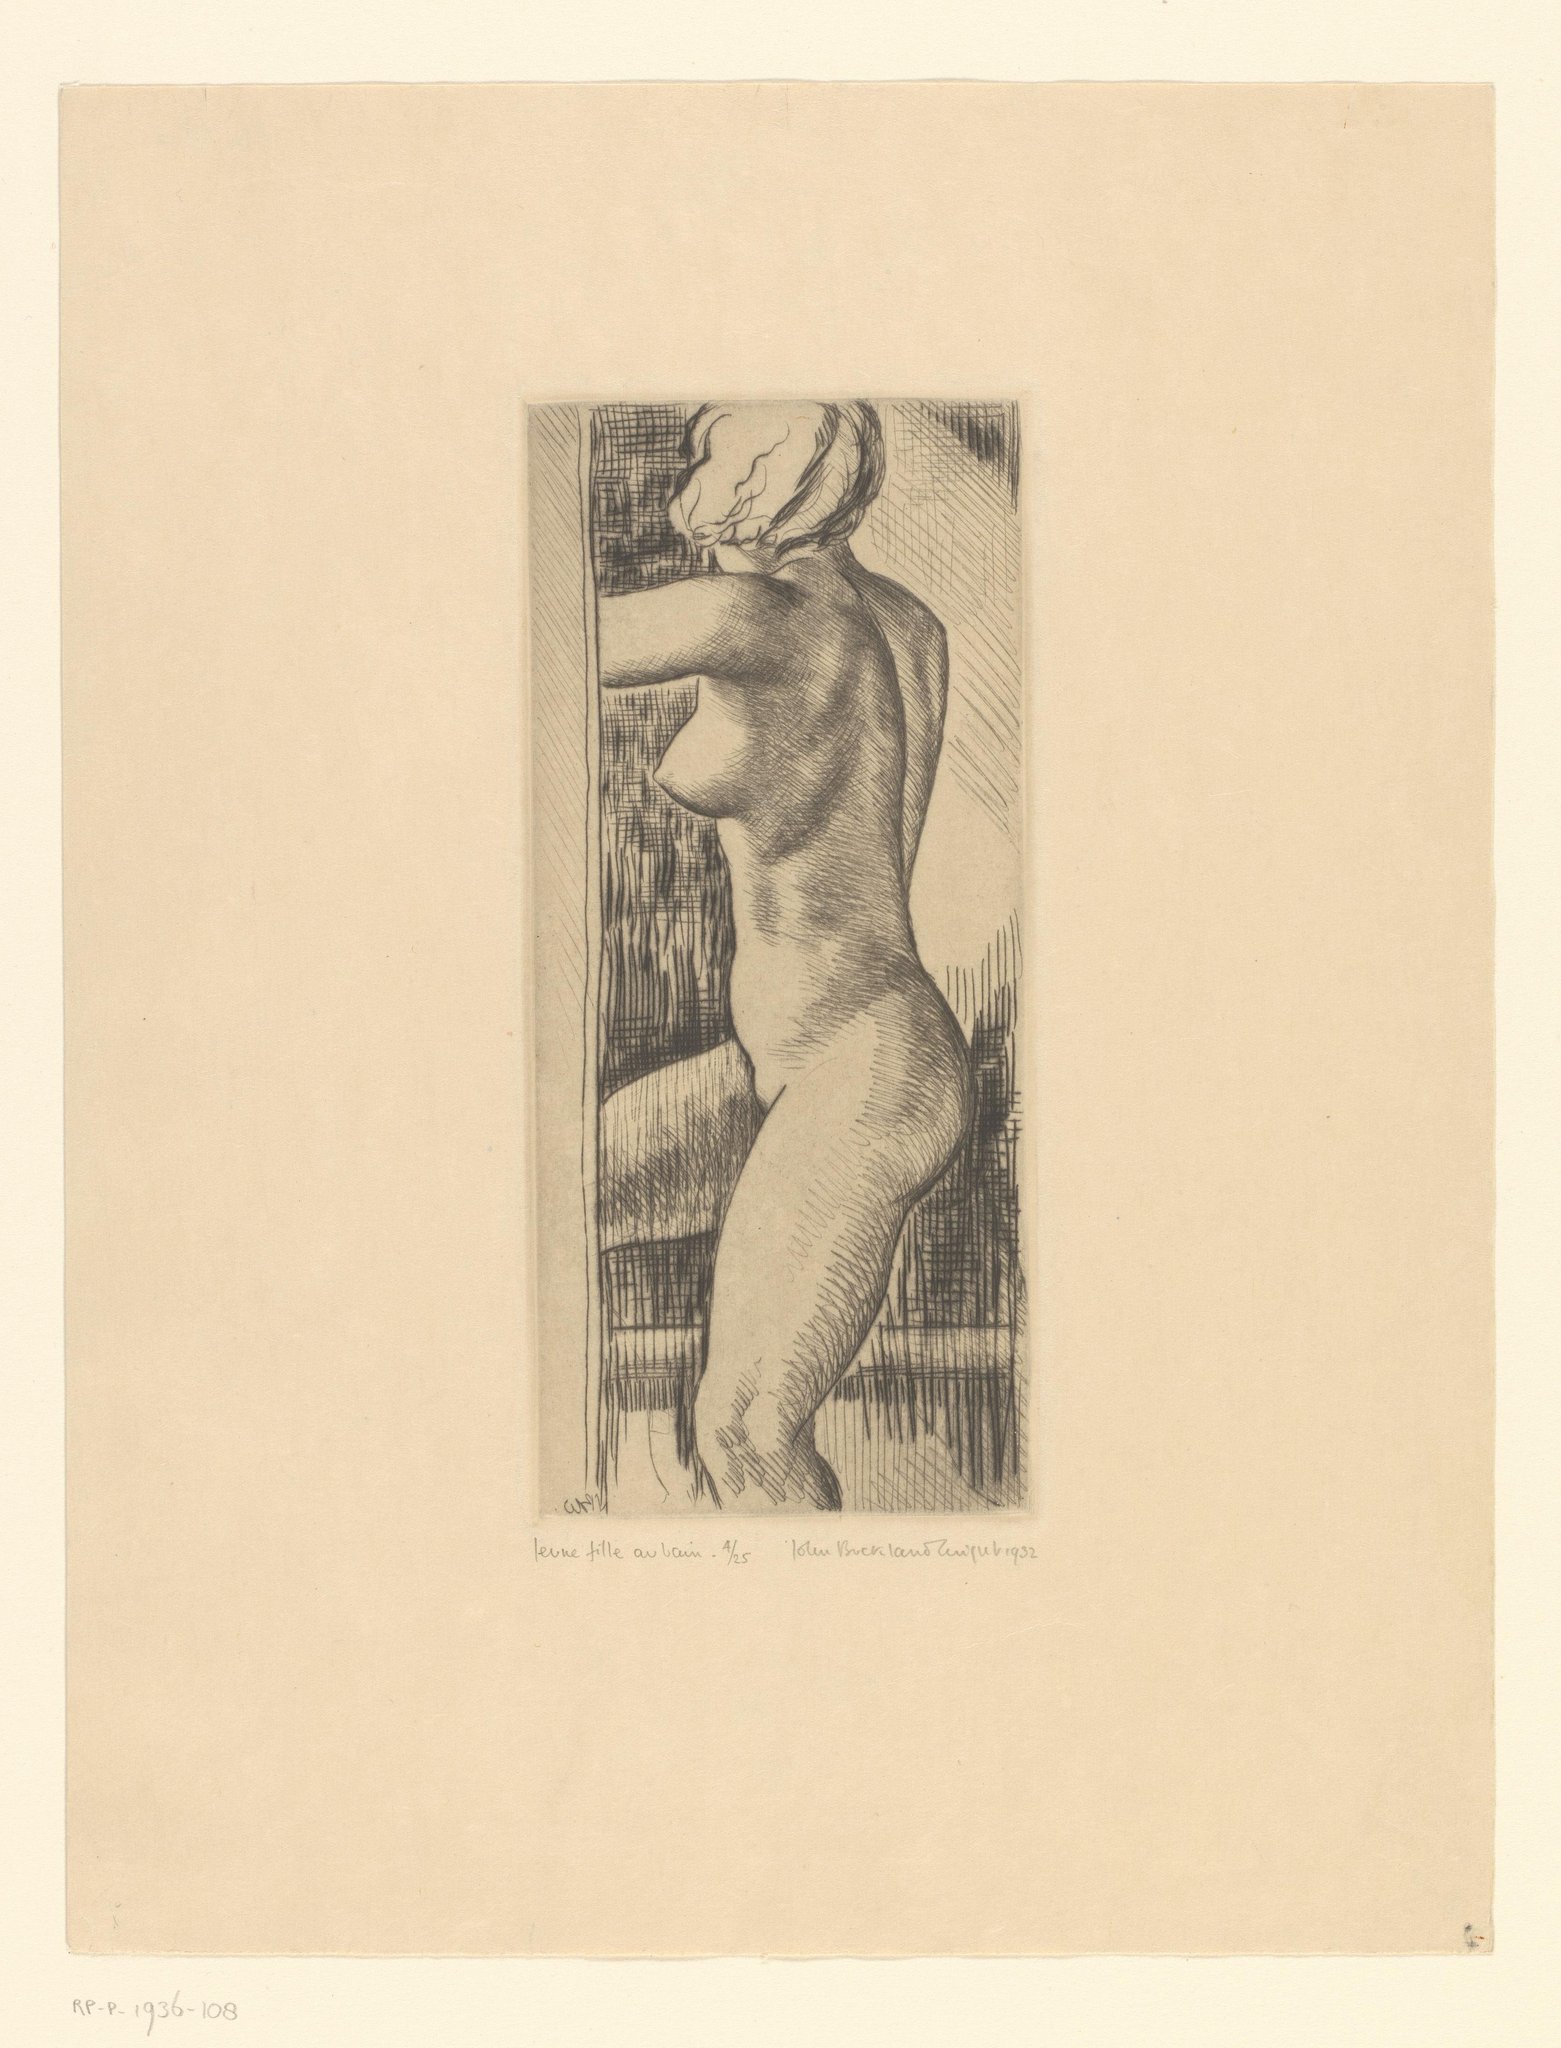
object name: print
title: Jeune fille au bain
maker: john buckland wright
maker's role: print maker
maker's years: 1897-1954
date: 1932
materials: paper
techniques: drypoint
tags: taking a bath, the (nude) human figure; 'corpo humano' (ripa) - aa - female human figure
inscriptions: collector's mark: Lugt 2228